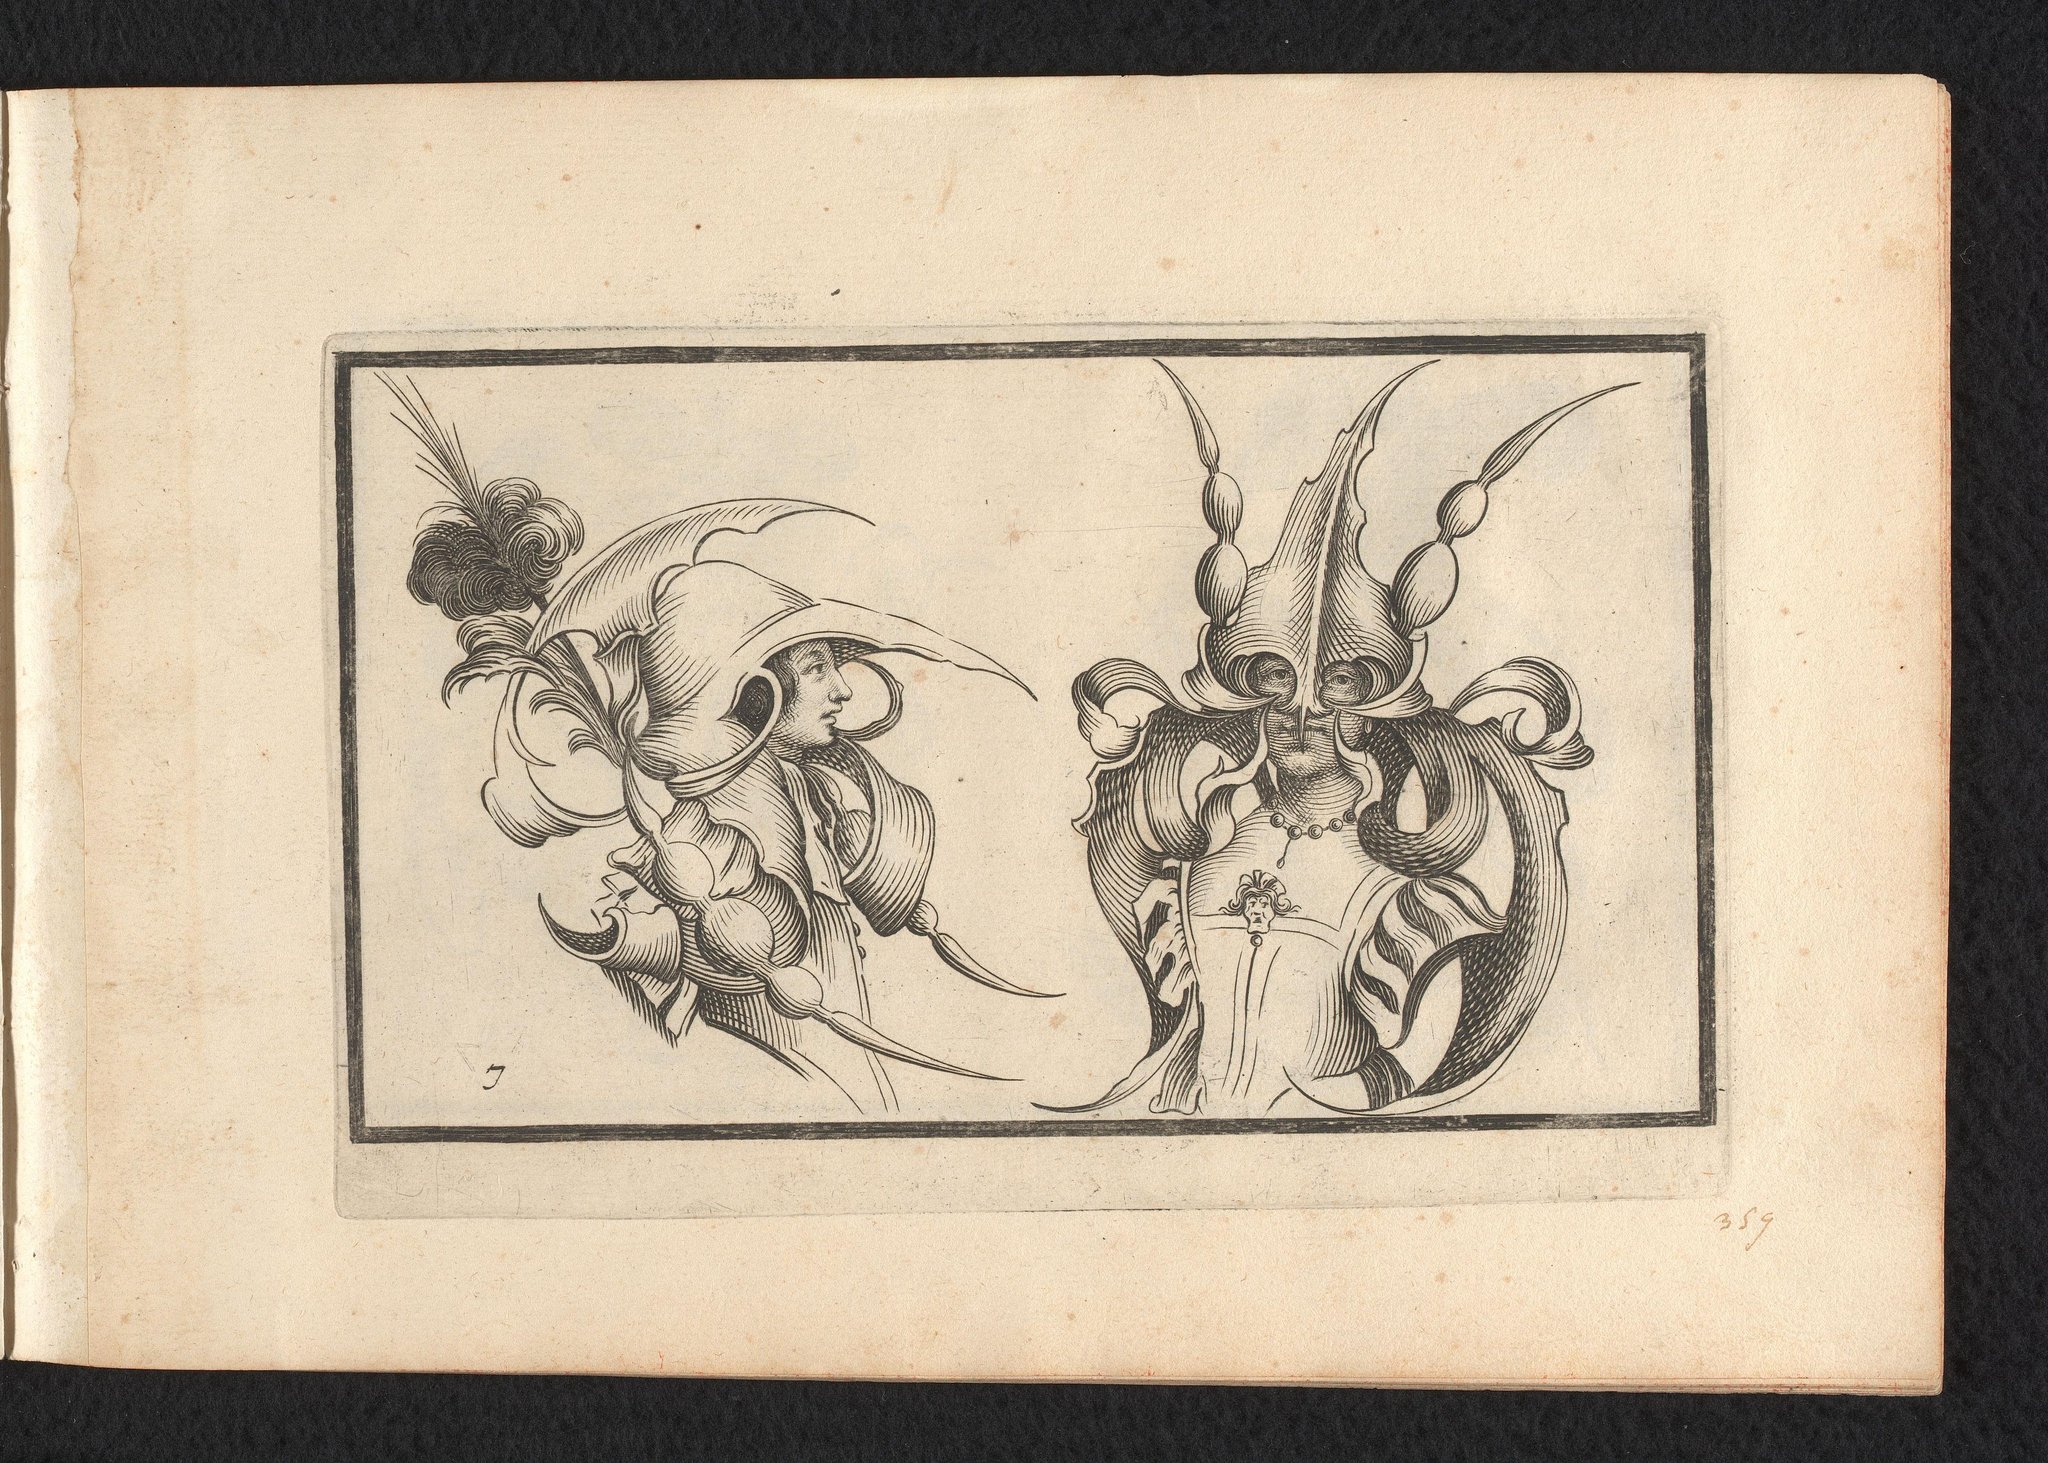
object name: ornament print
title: Ontwerpen voor hoofddeksels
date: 1636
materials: paper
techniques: engraving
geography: paris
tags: ornaments ~ art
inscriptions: collector's mark: Lugt 2760, number: ‘359’, collector's mark: Lugt 2228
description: Deze prent maakt deel uit van een album.